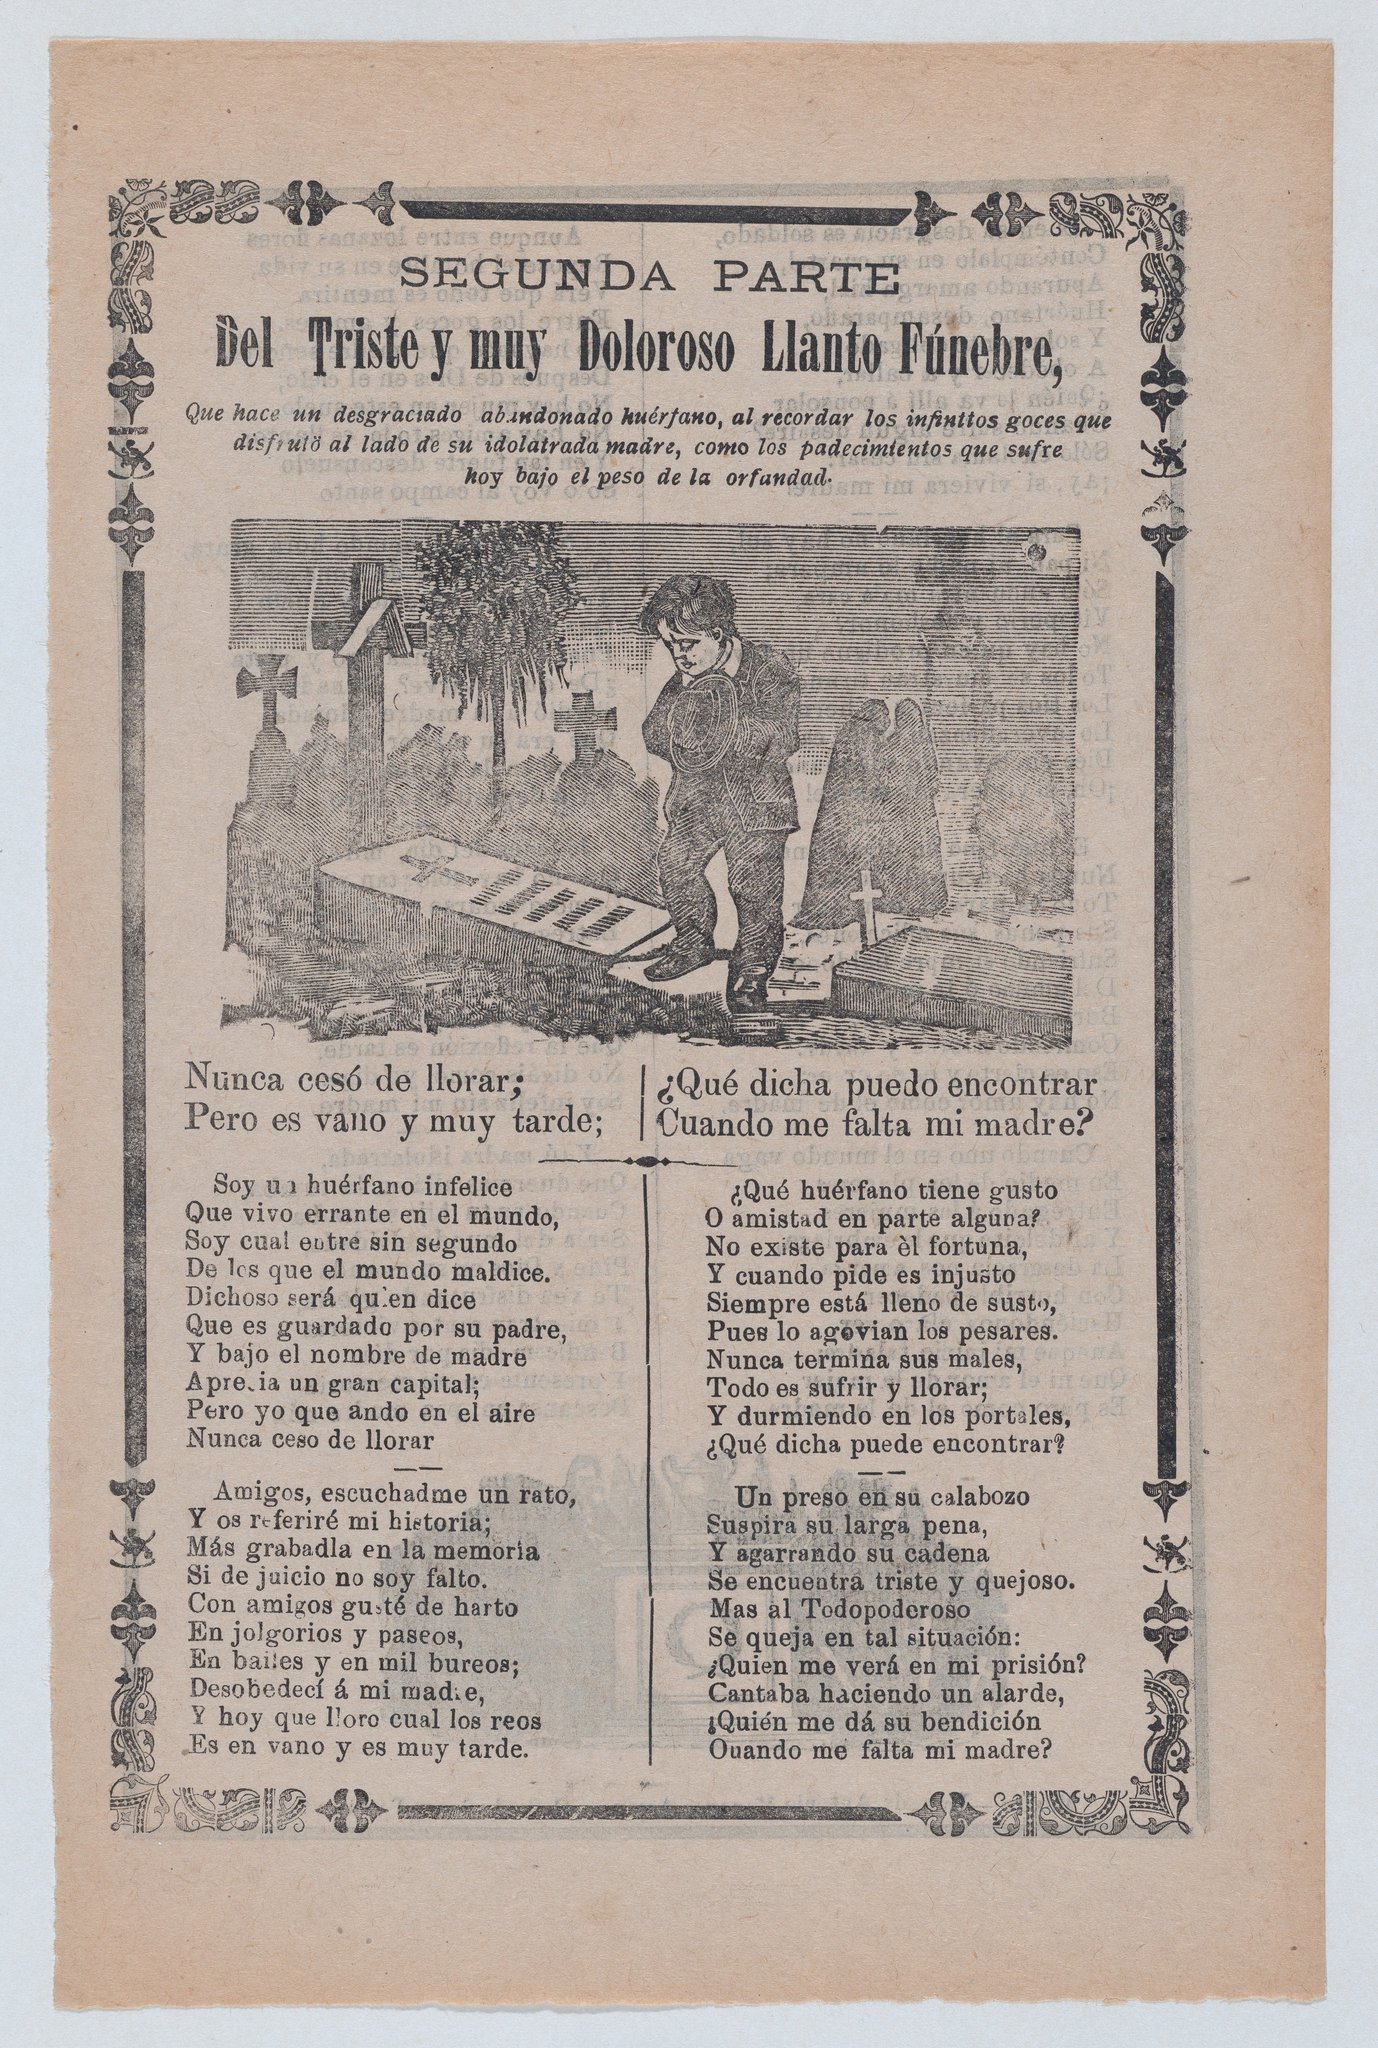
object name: print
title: Broadsheet relating to the plight of an orphan, young boy mourning in a cemetery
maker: josé guadalupe posada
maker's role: artist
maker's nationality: mexican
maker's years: 1852-1913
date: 1900-1913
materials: metal, paper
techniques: engraving, letterpress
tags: burial grounds,boys,cross,burials